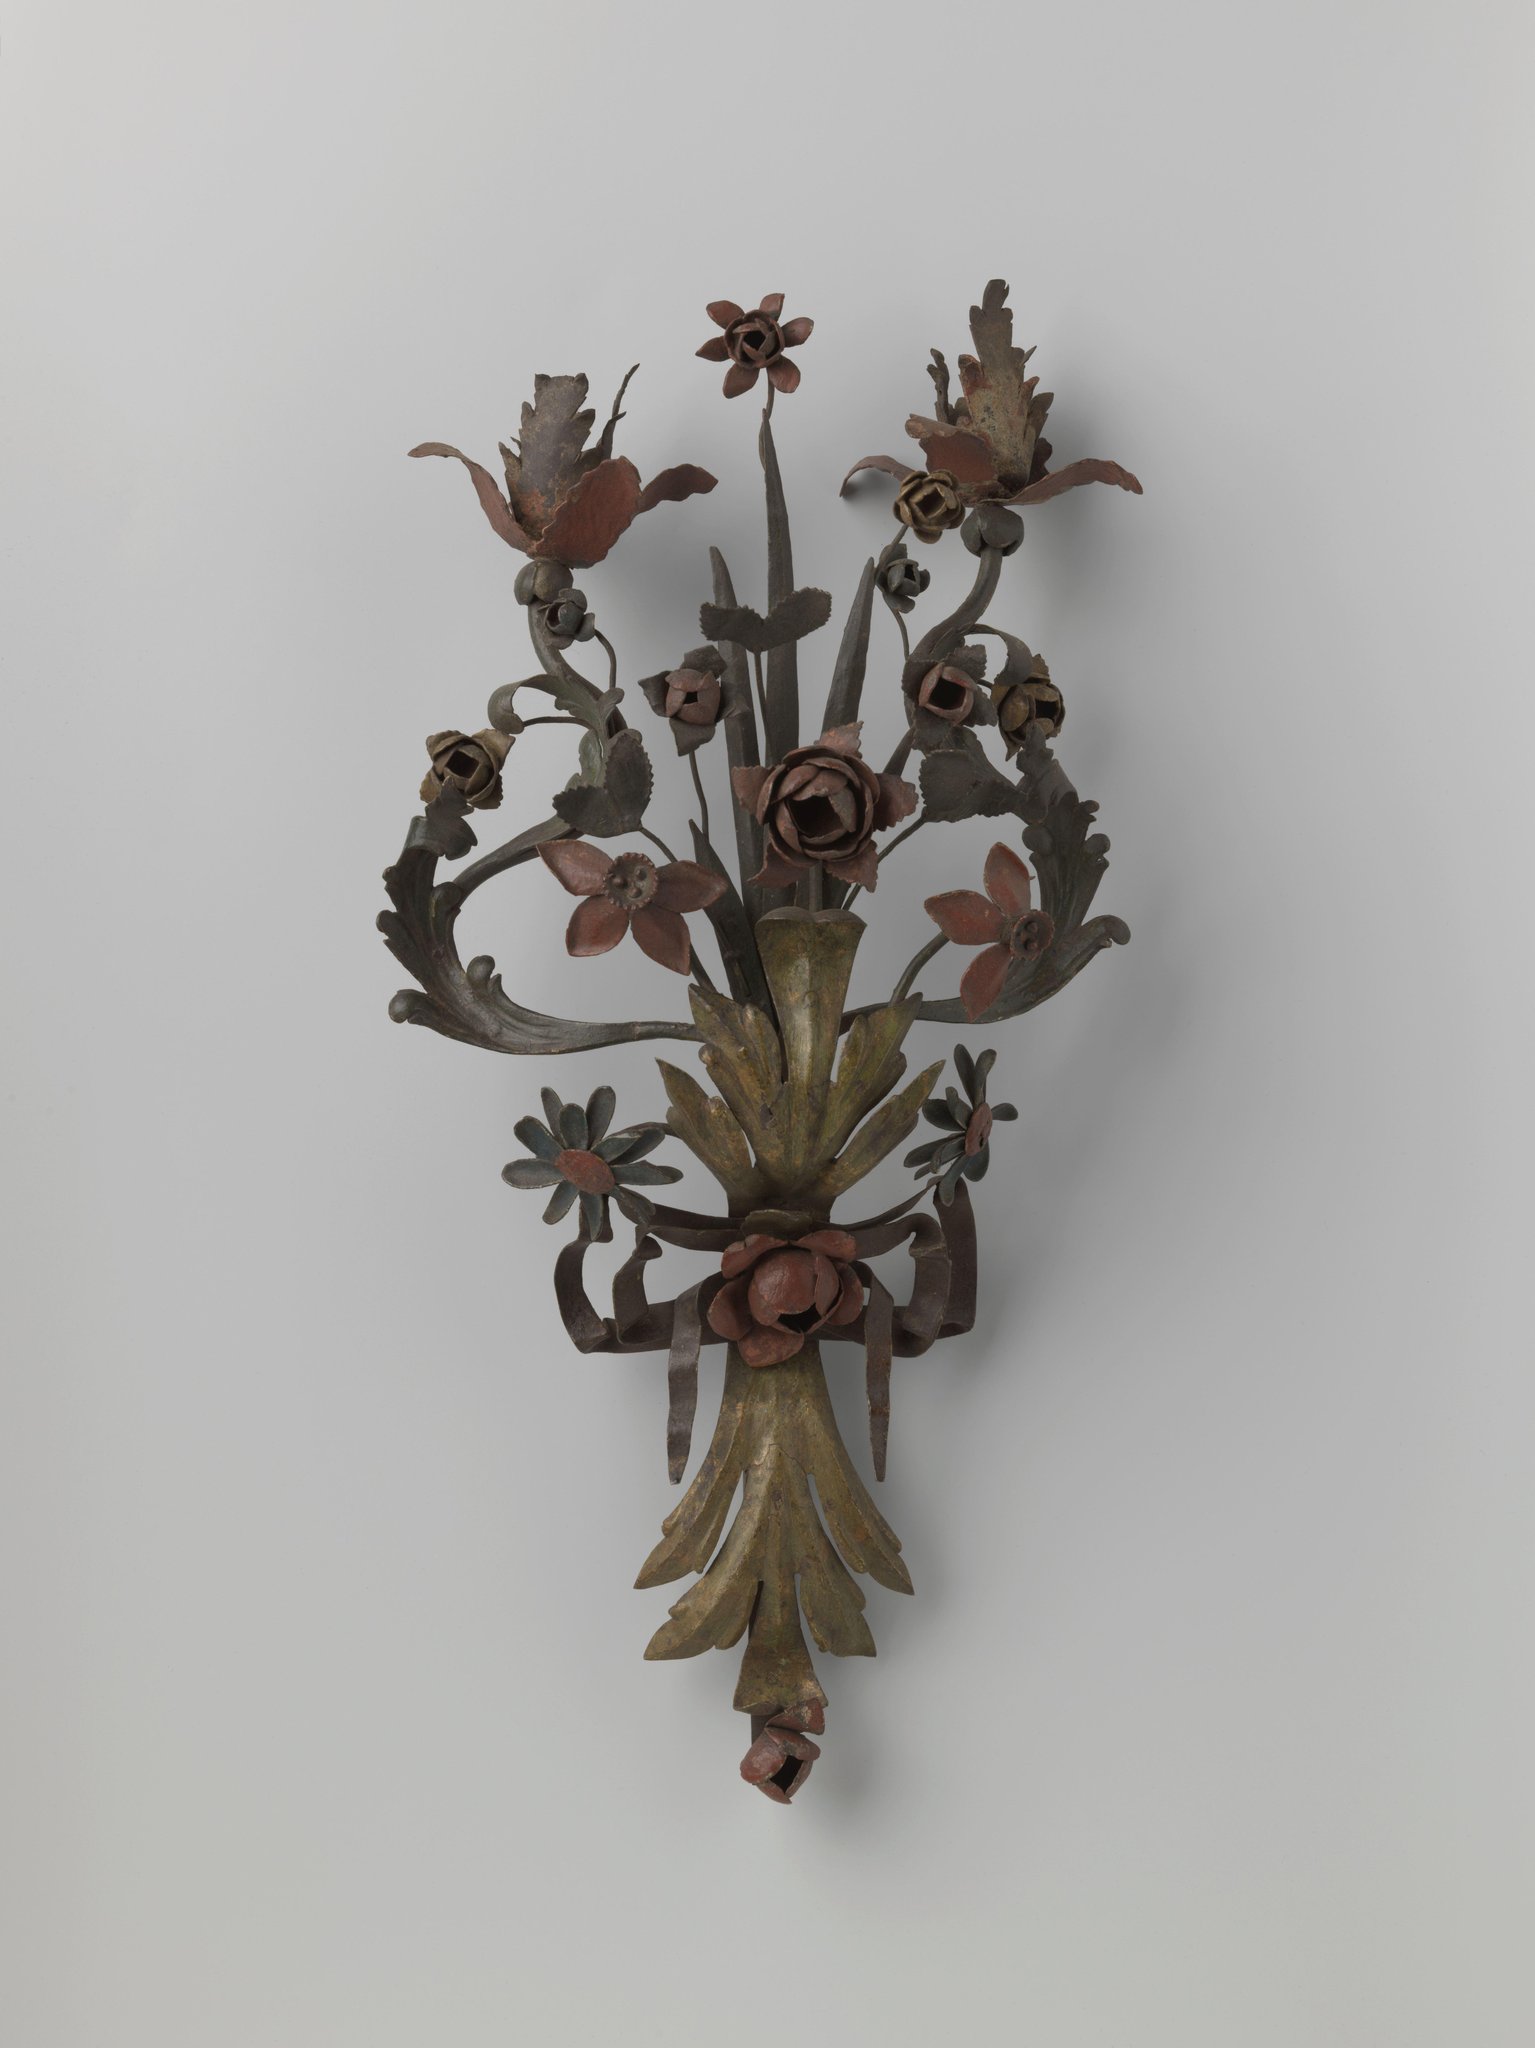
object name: sconce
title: Wandarm, waarvan de armen en de kaarsenhouders zijn vormgegeven als bloemtakken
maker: Anonymous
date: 1700-1750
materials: iron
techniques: forging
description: Een ijzer gesmeed altaarboeket. Met de oorspronkelijke kleuren beschilderd.